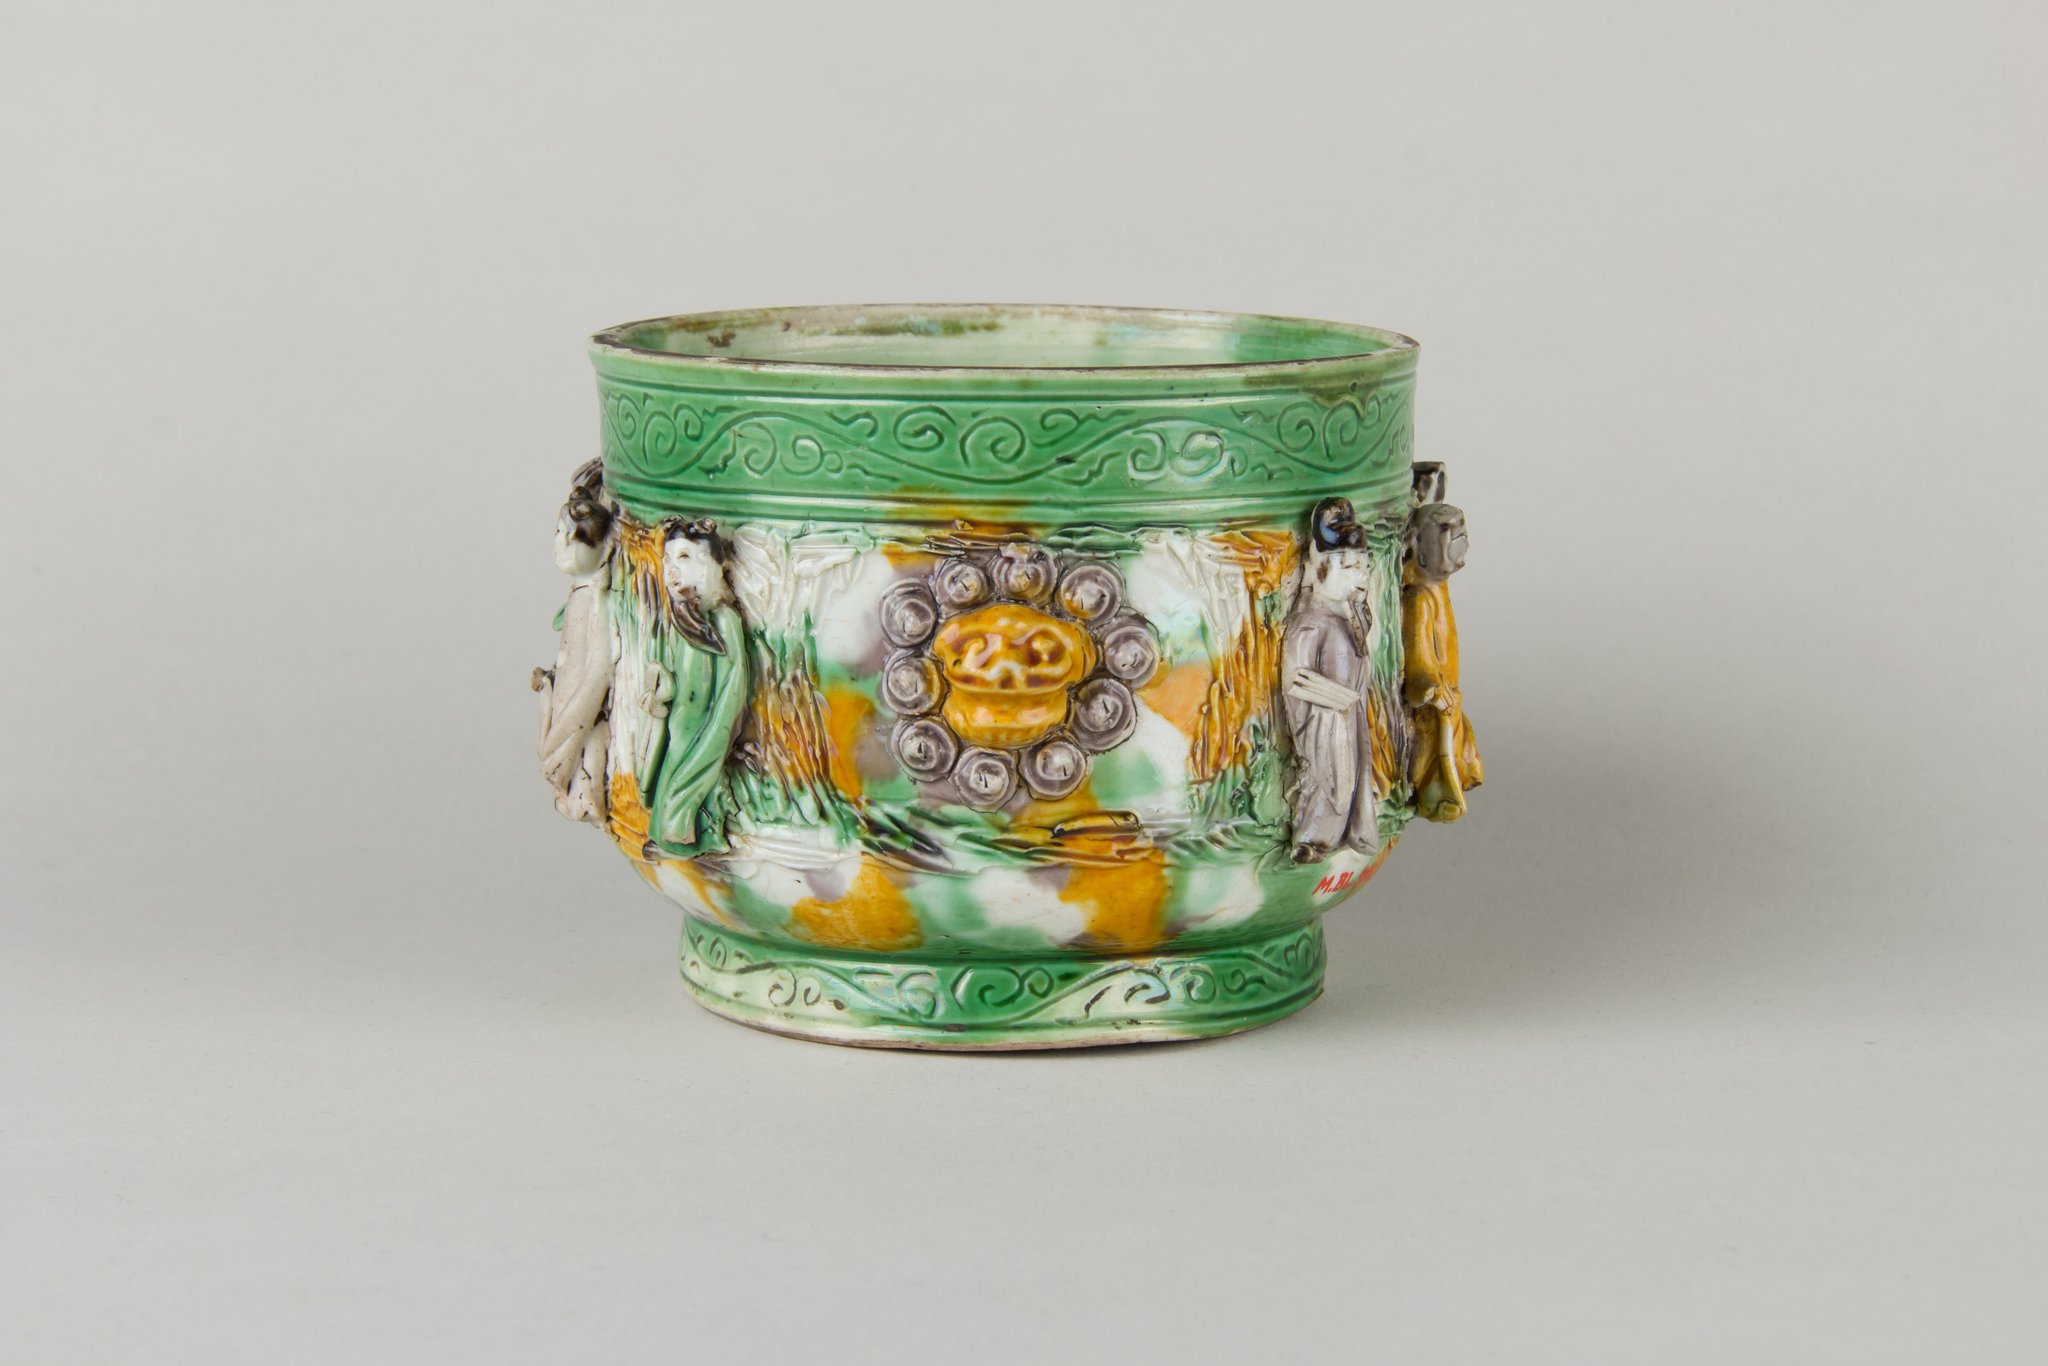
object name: bowl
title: Bowl with Eight Immortals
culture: chinese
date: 1368-1644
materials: biscuit, enamel, porcelain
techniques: polychrome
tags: human figures